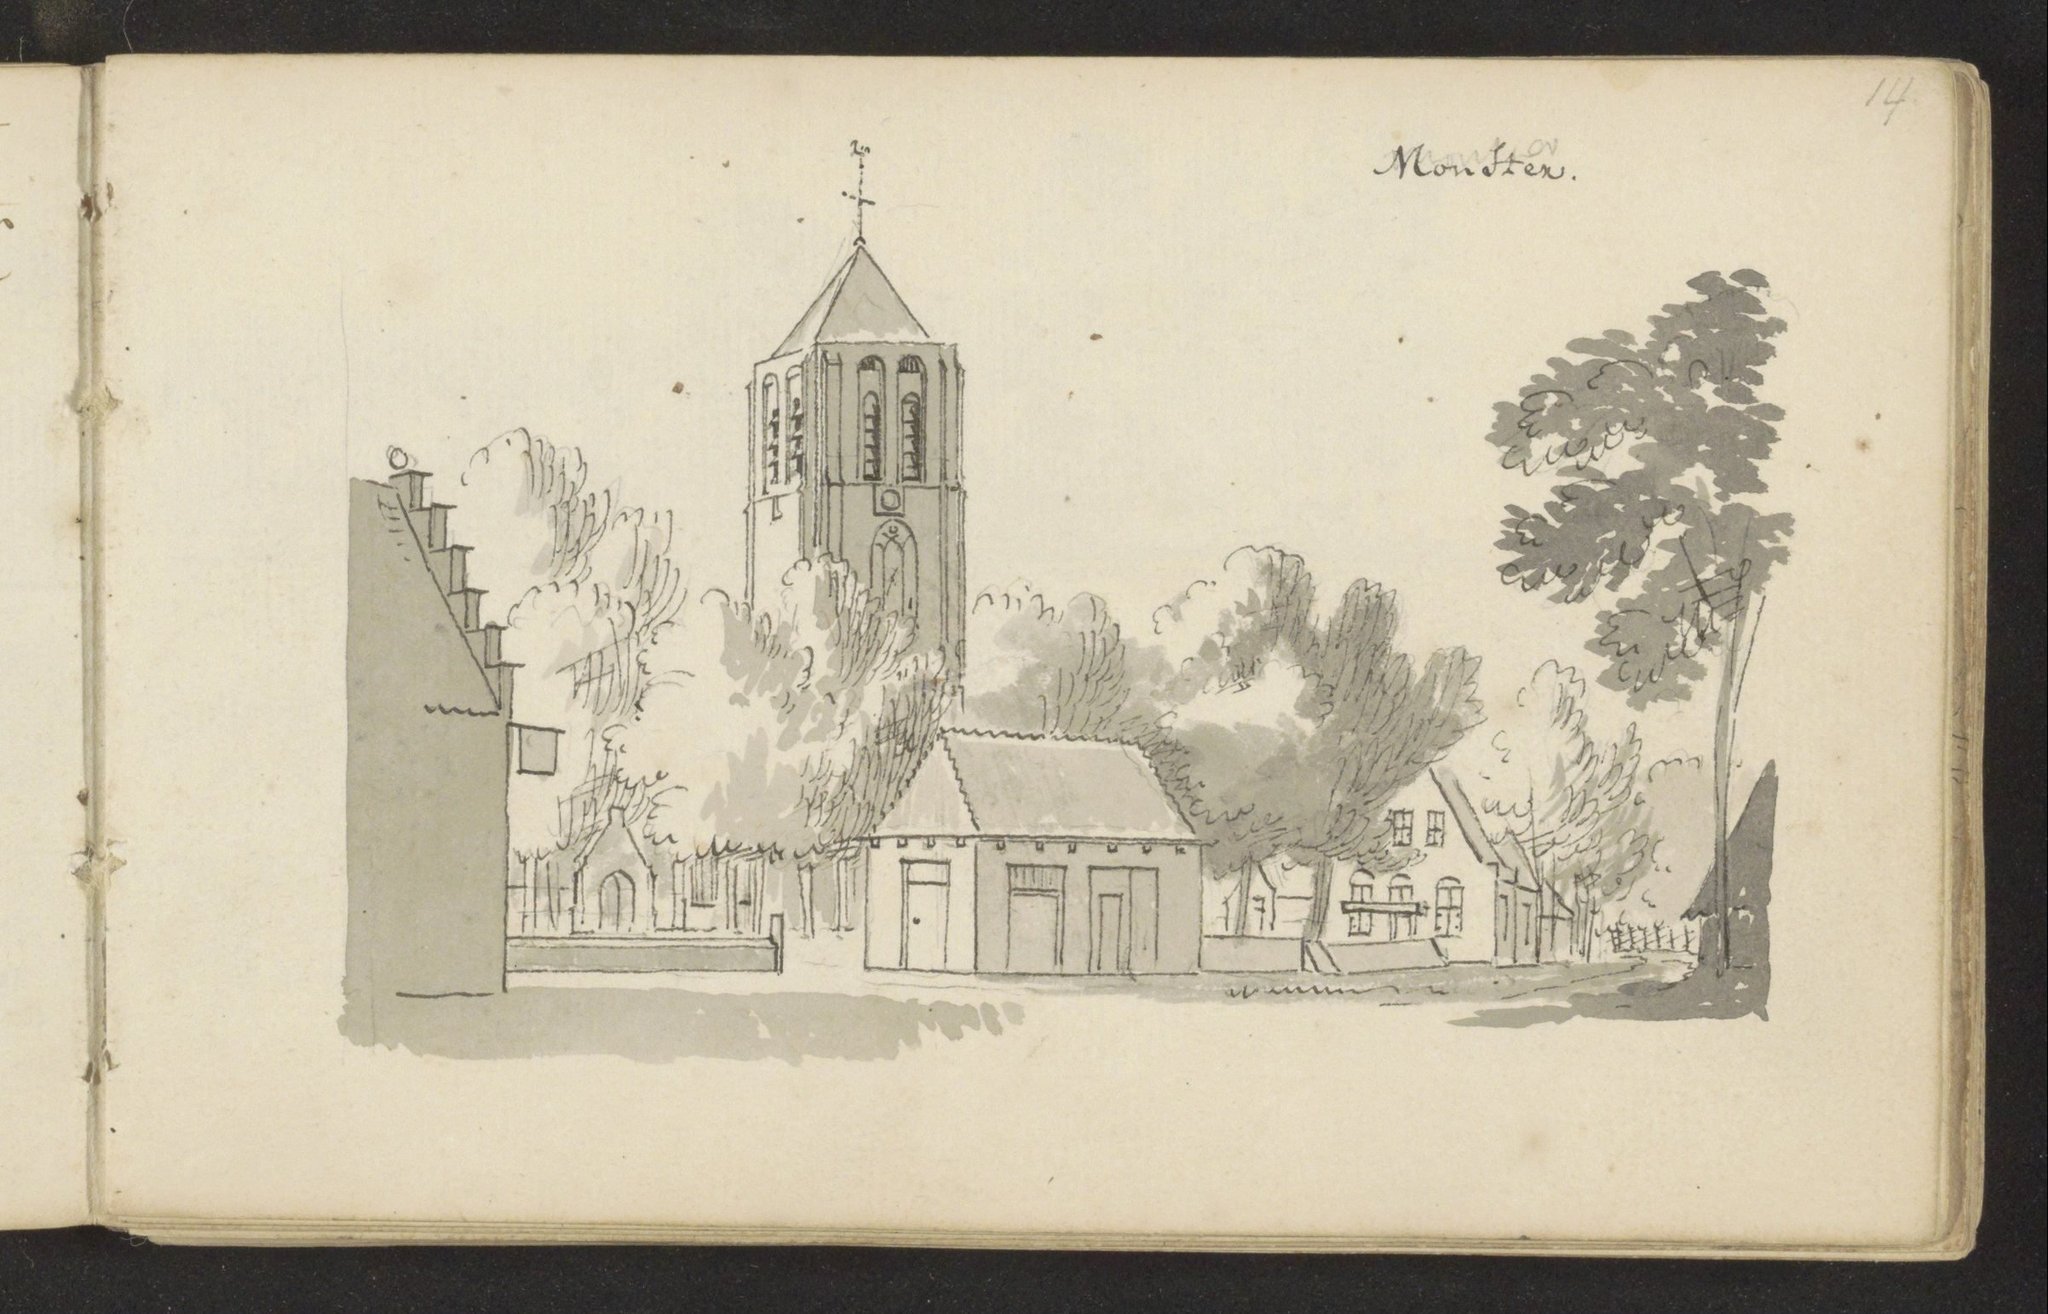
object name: sketchbook leaf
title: Dorpsgezicht met kerk te Monster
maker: abraham de haen (ii)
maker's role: draughtsman, print maker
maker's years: 1707-1748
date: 1731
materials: ink, paper, pencil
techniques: brush, pen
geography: monster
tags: public road in village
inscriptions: annotation: ‘Monster’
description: Blad 14 recto uit een schetsboek met 78 bladen.